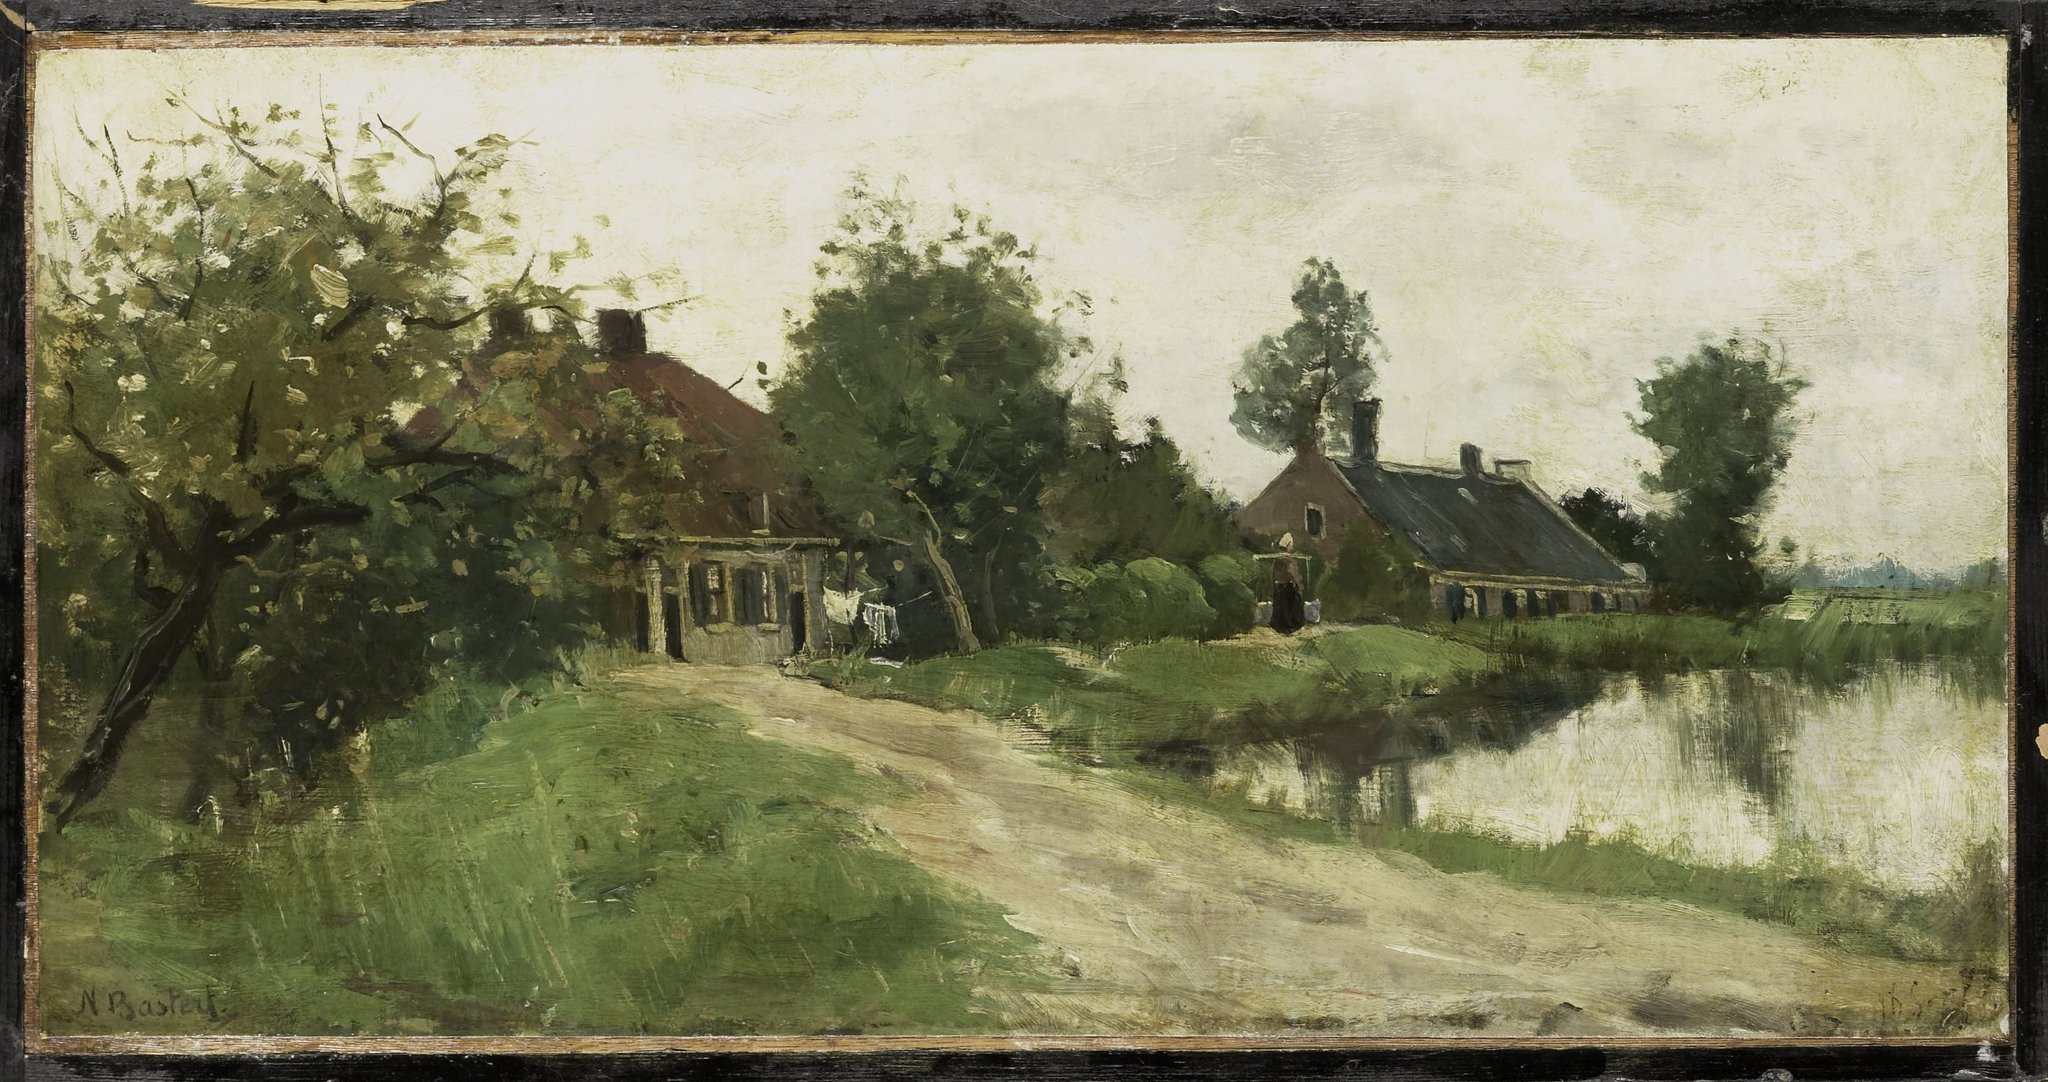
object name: painting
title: Near Breukelen on the Vecht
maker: nicolaas bastert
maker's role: draughtsman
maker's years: 1854-1939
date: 1870-1923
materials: oil, panel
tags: river, canals, waters (in village), vecht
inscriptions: signature: ‘N Bastert’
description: Riverlandschap bij Breukelen. Enkele boerenwoningen gelegen aan zandweg aan een bocht van een water. Op de weg loopt een boerin met een juk met melkemmers.